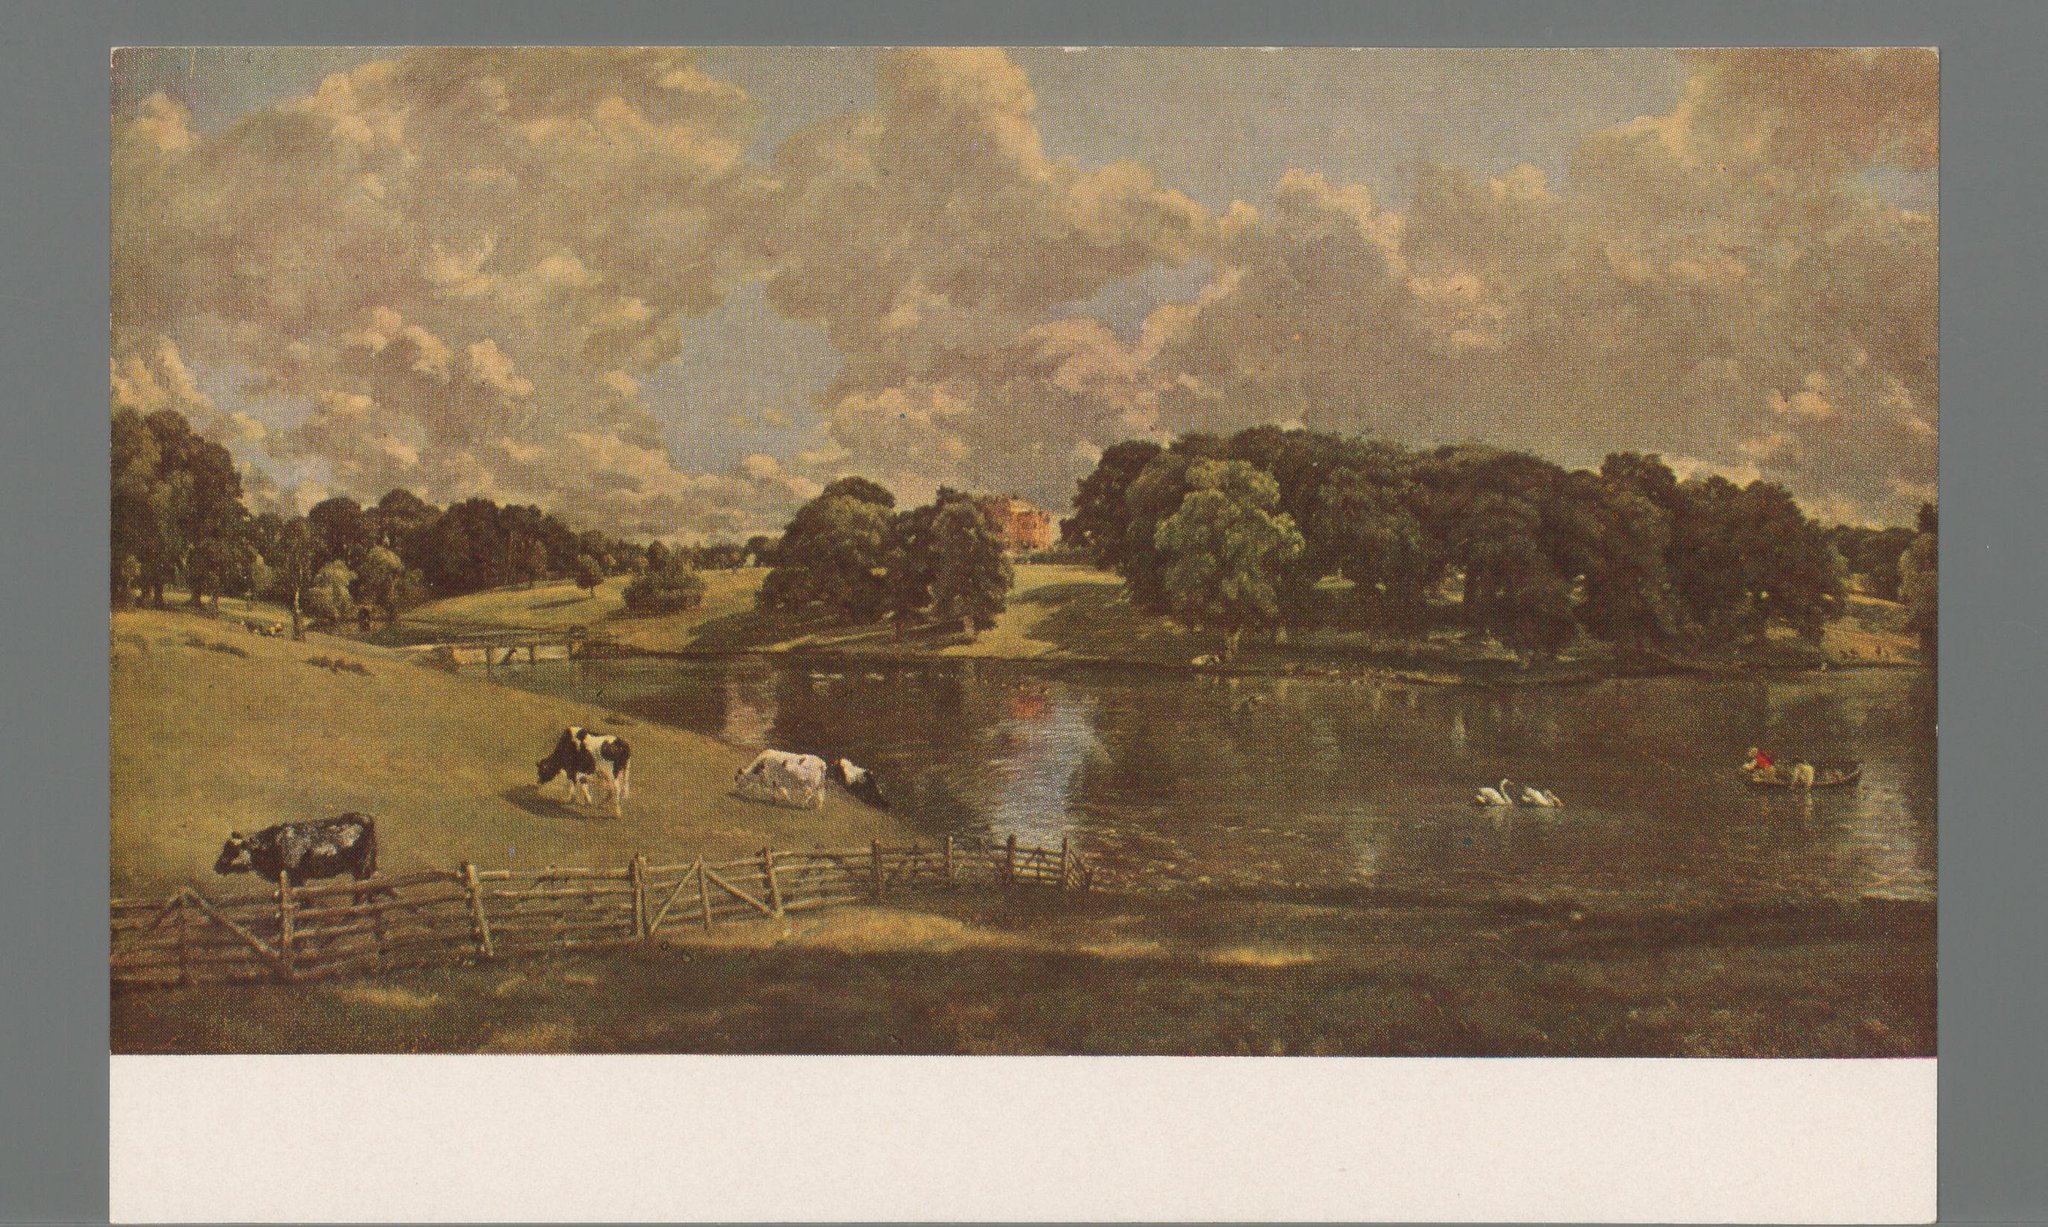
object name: ansichtkaart, prentbriefkaart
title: Wivenhoe Park, Essex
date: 1942-1970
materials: cardboard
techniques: four-color autotype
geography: washington d.c.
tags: park, cow, pond, pool (+ landscape with figures, staffage)